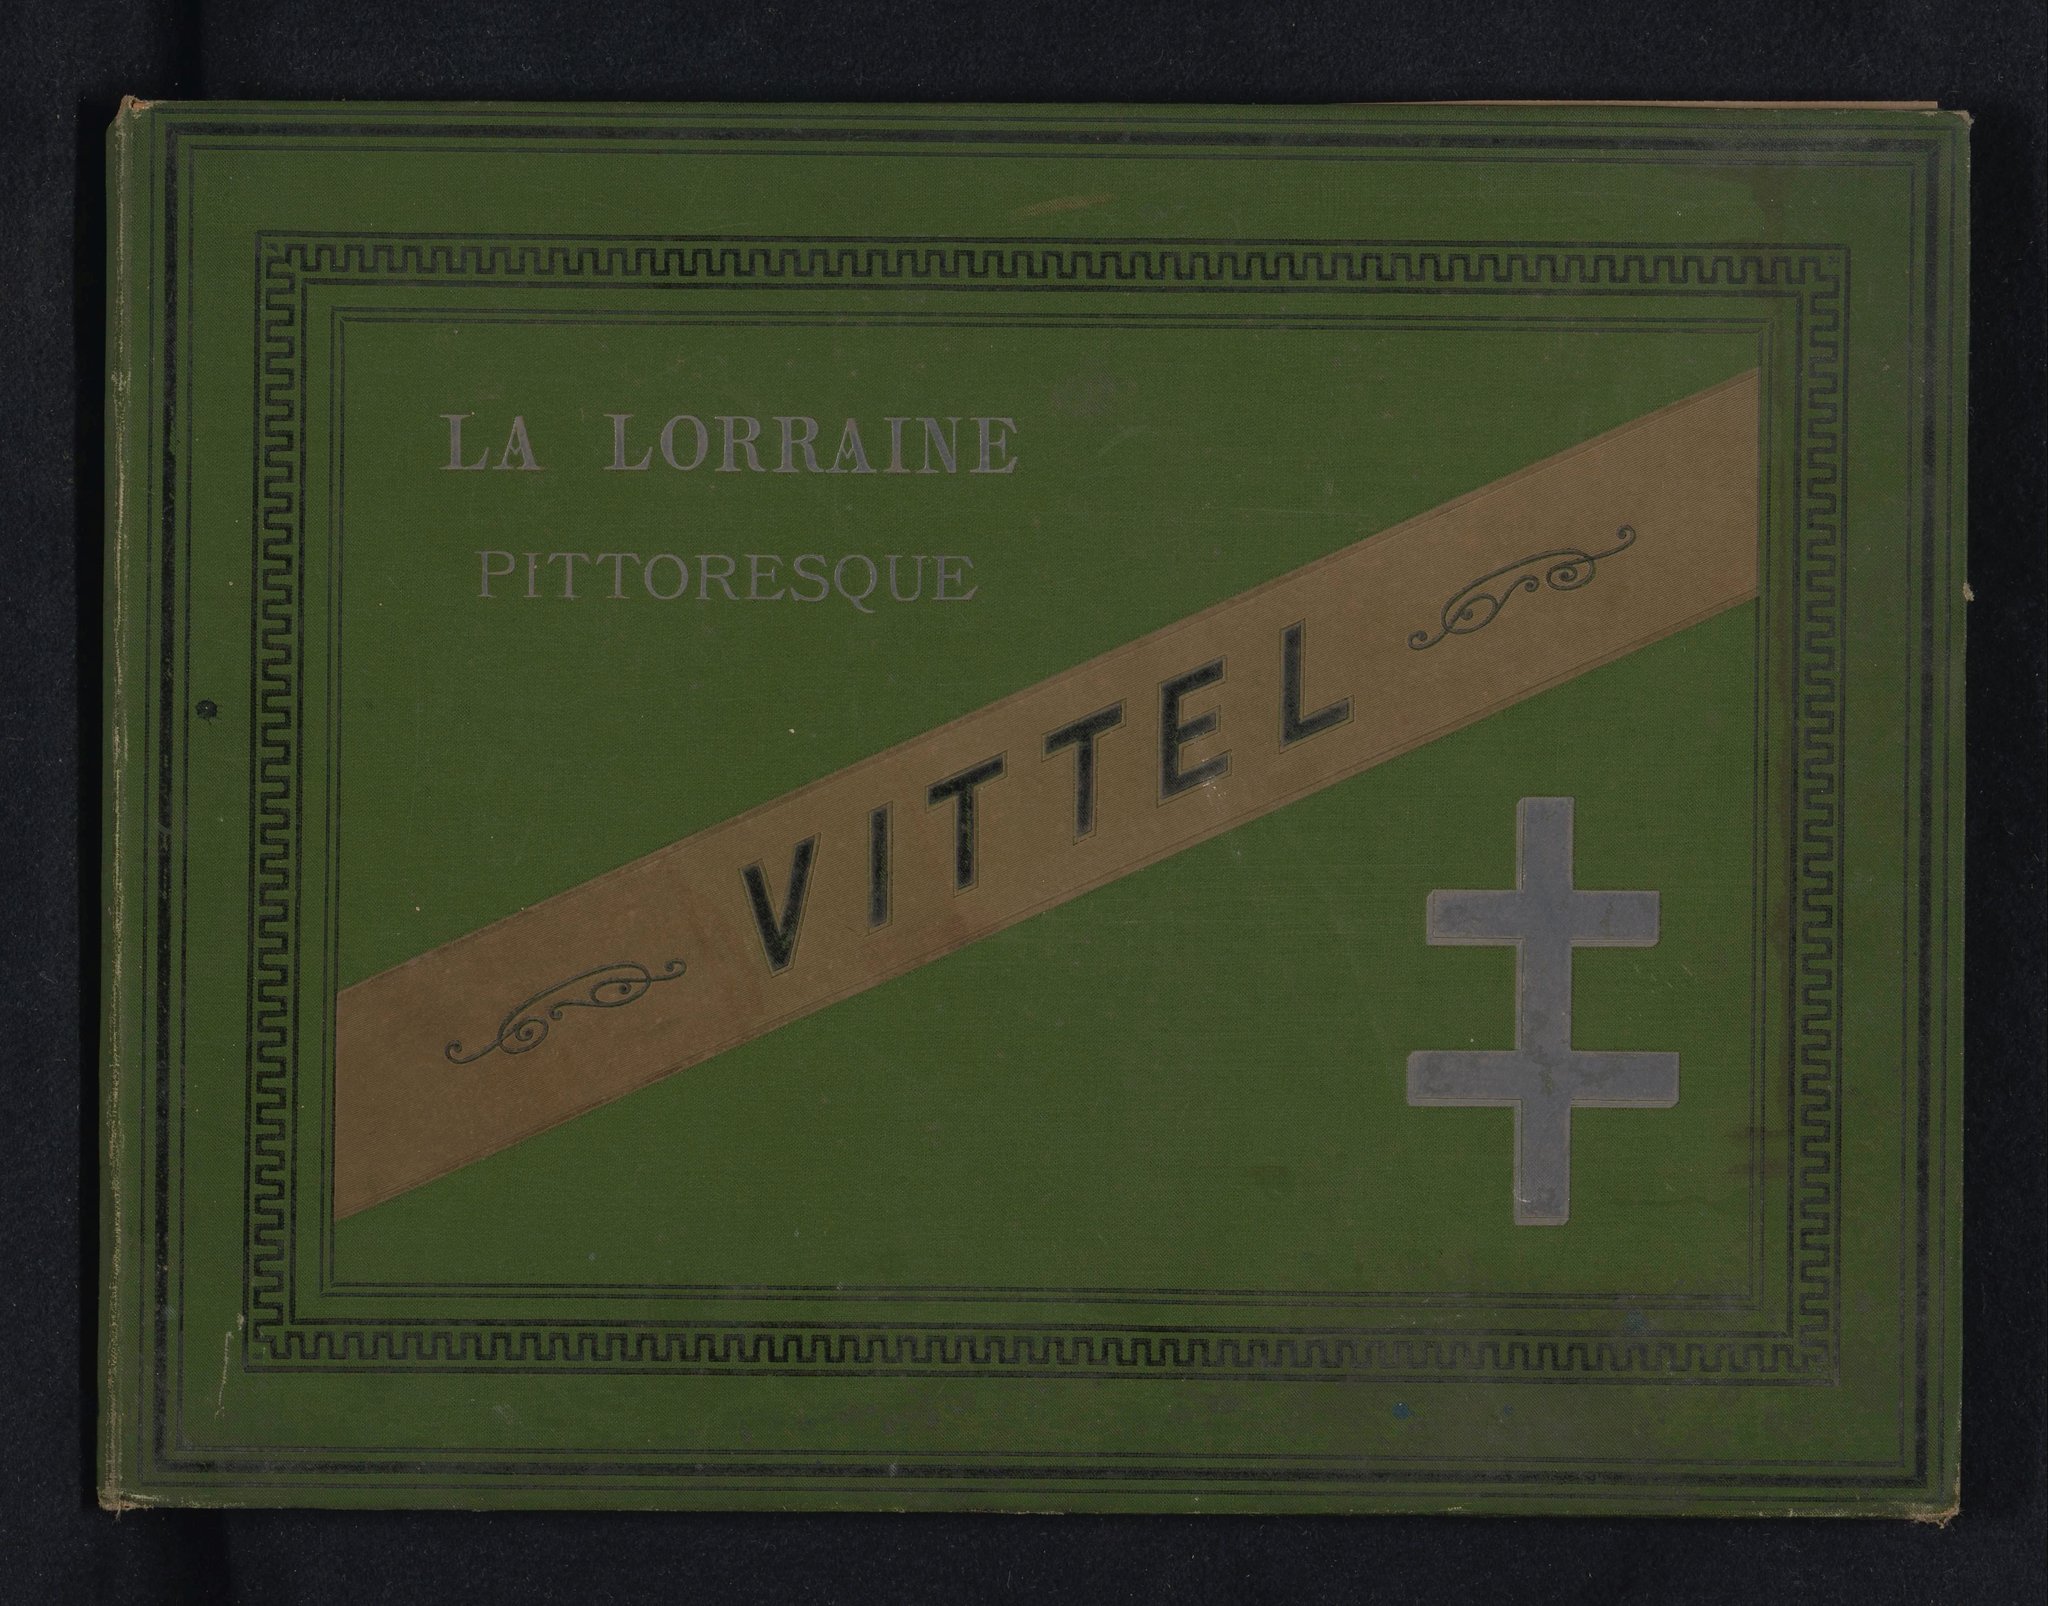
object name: book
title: La Lorraine pittoresque : Vittel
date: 1890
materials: cardboard, linen, paper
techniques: photograph, printing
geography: paris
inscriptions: annotation: ‘MAY/ 1996’, annotation: ‘Nr 150/ 9[..]’